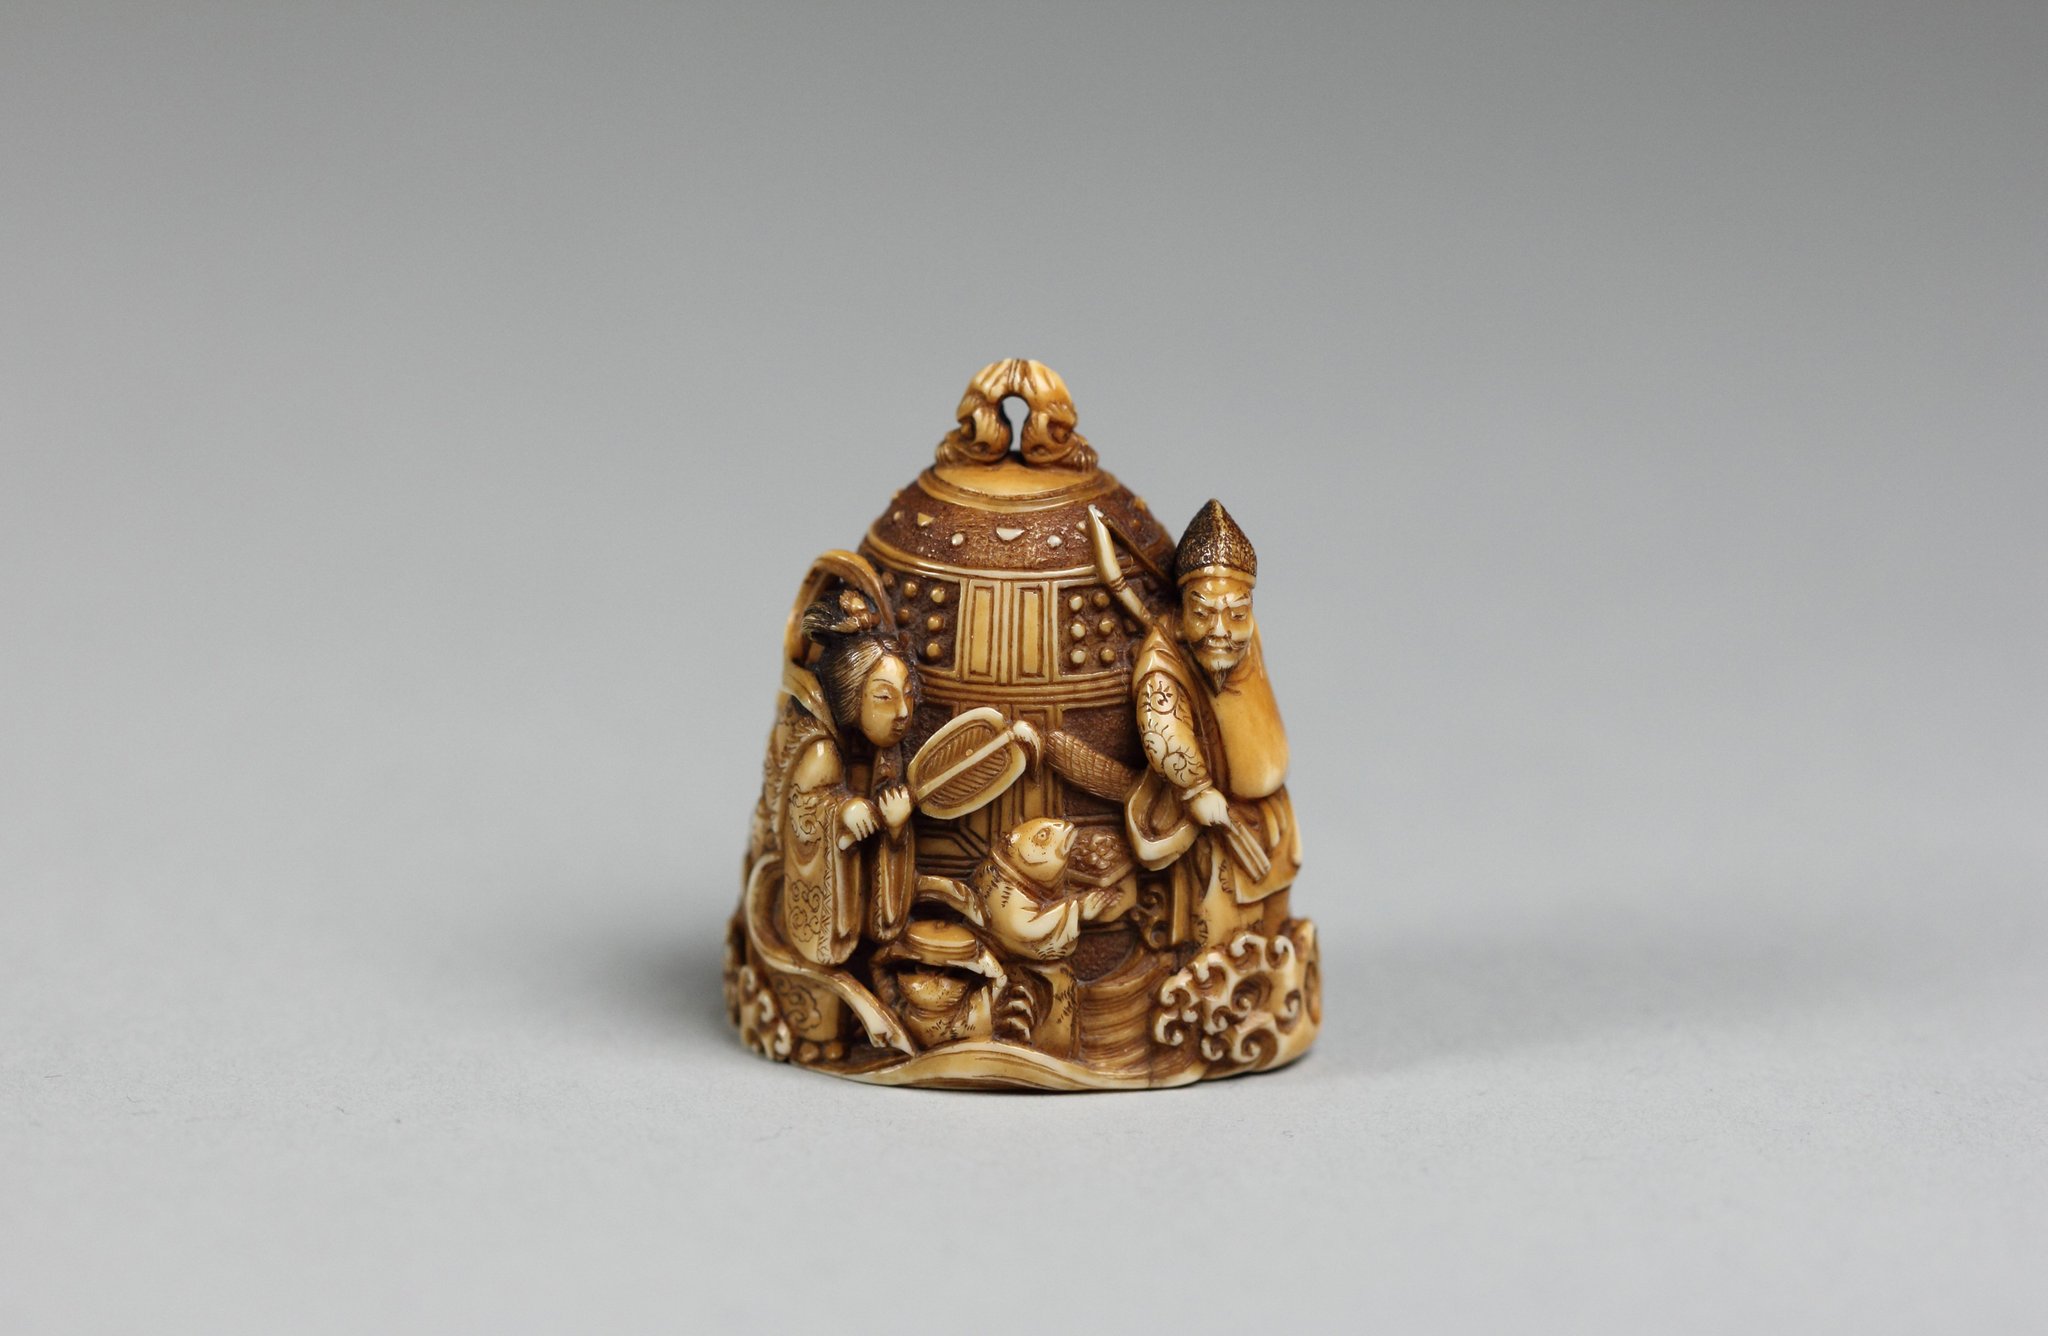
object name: netsuke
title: Netsuke in the form of a Bell Ornamented with Waves and Figures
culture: japanese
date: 1867-1900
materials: ivory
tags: men